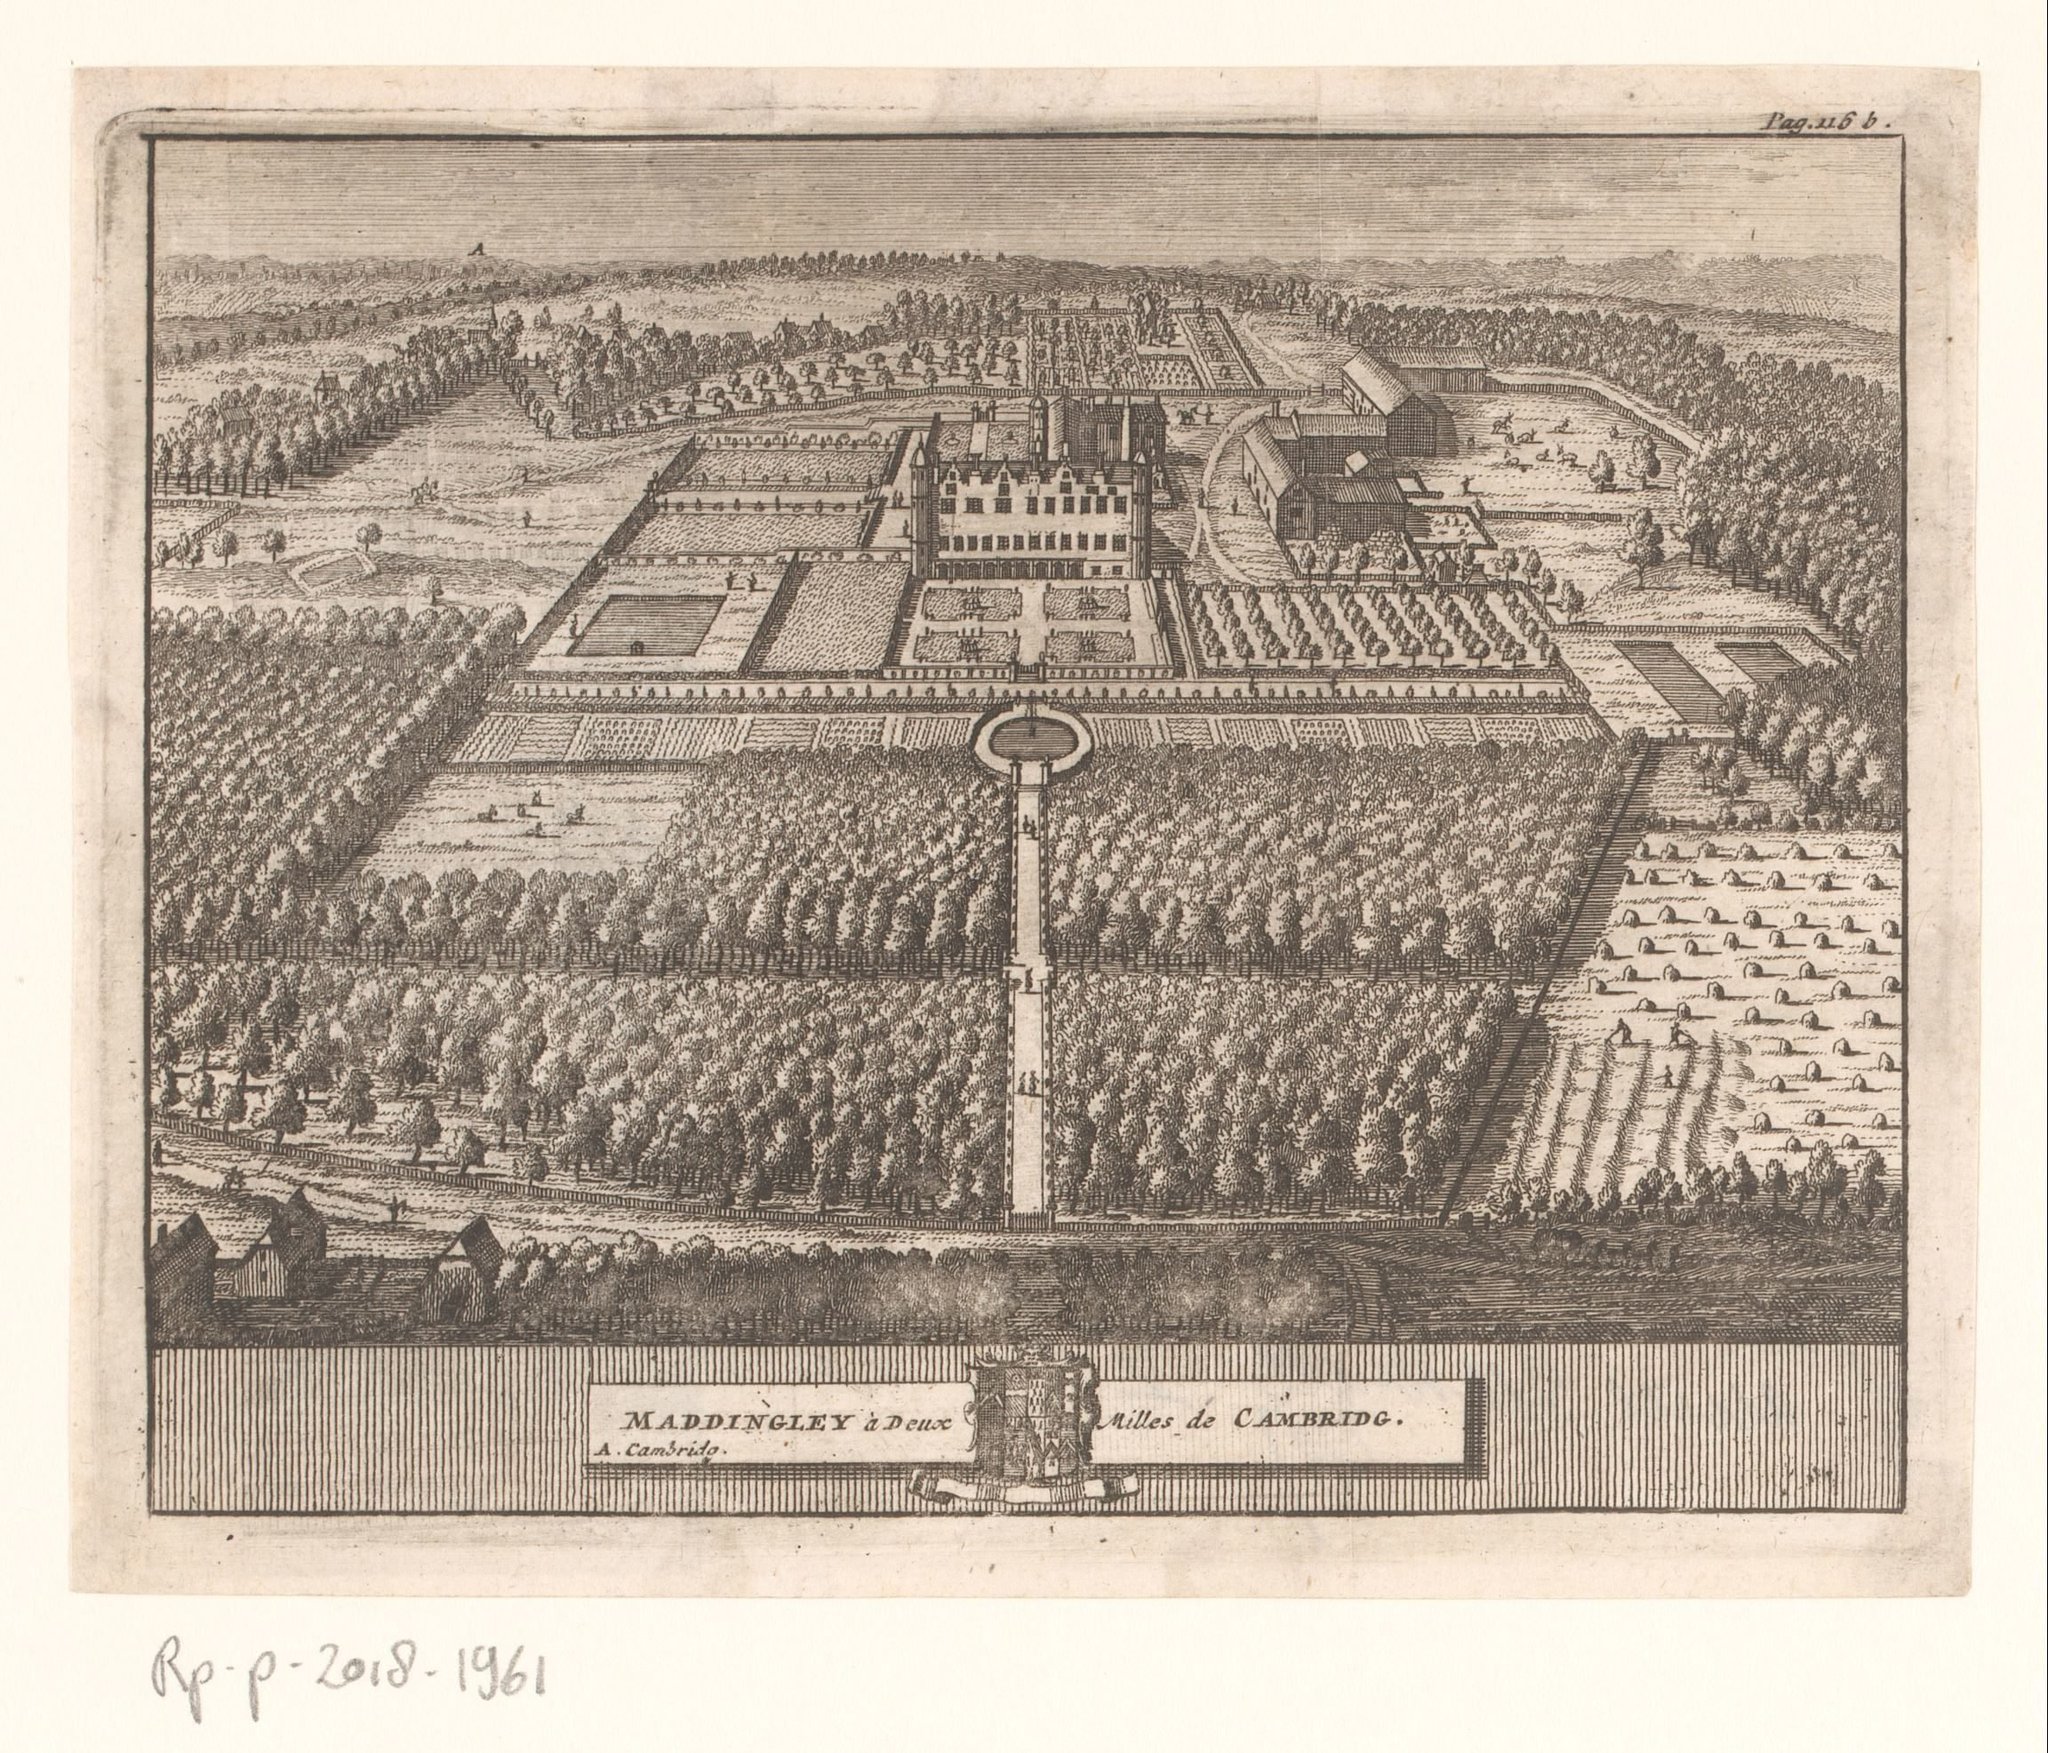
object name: print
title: Gezicht op Madingley Hall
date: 1707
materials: paper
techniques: etching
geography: leiden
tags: castle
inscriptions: collector's mark: Lugt 2228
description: Prent gebruikt in: Beeverell, James. Les Delices de la Grande Bretagne et de l'Irlande (...). Leiden: Pieter van der Aa, 1707.